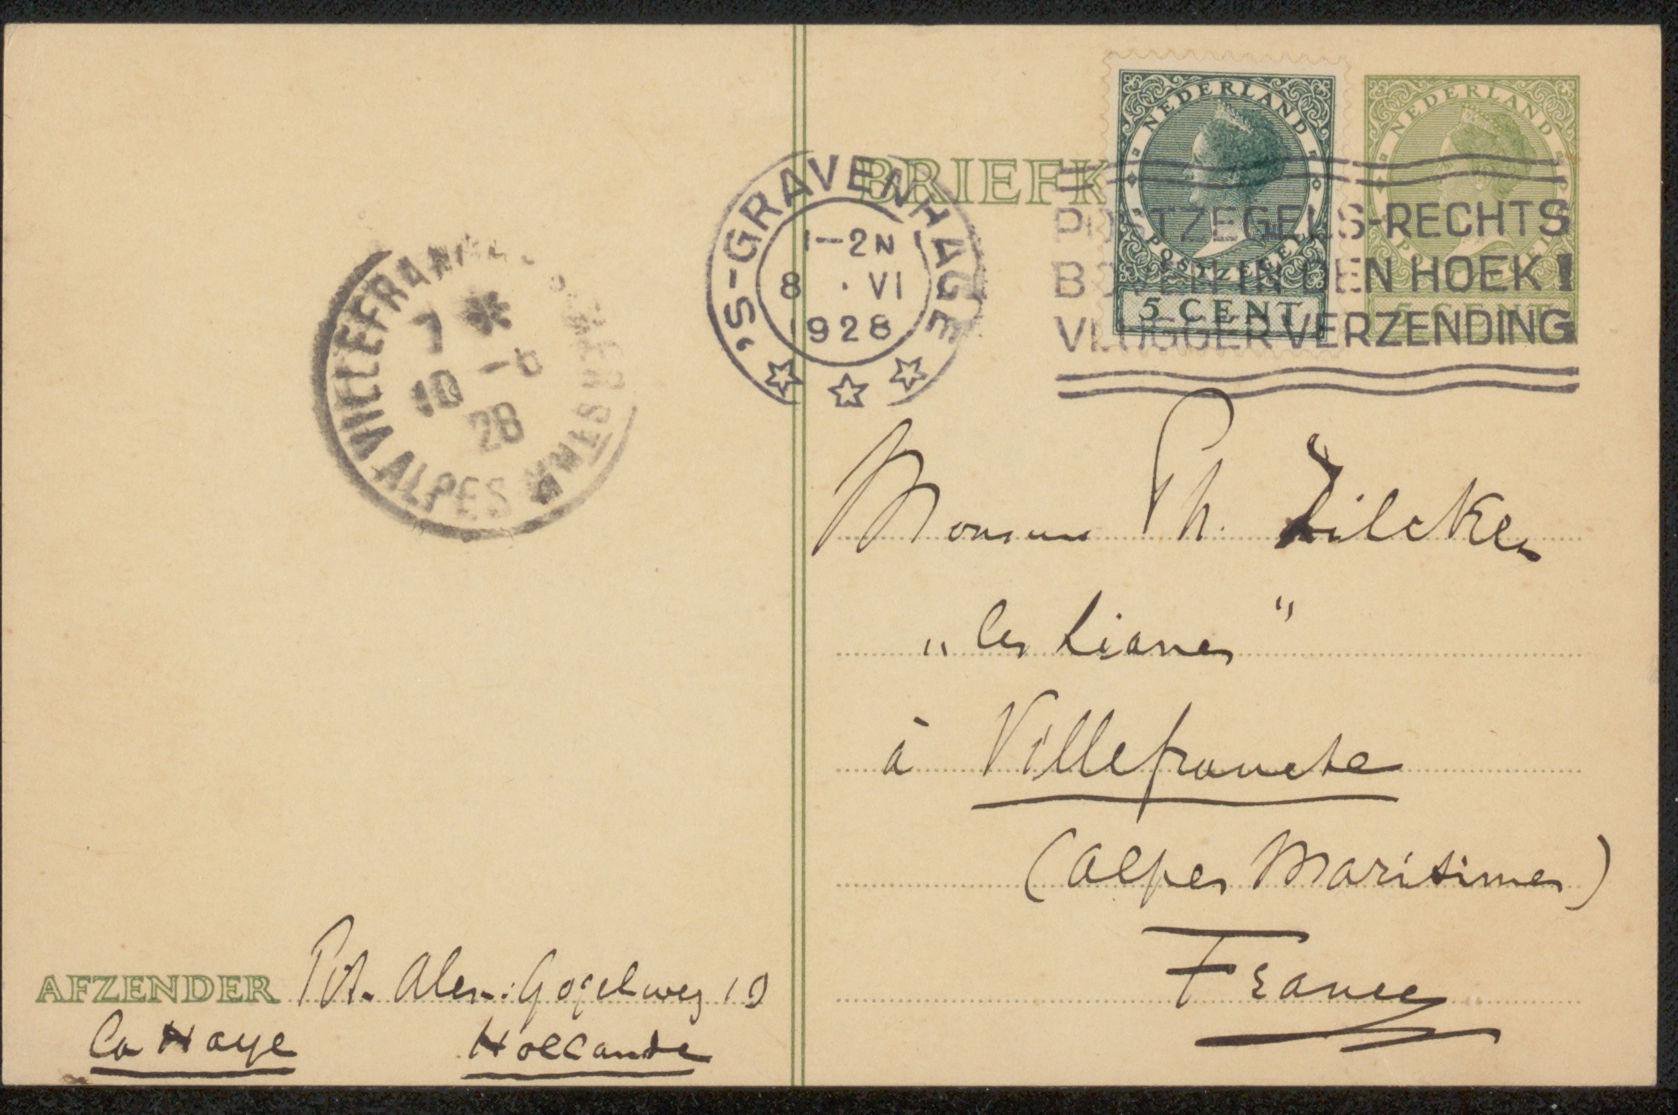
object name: postcard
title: Briefkaart aan Philip Zilcken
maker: adriaan pit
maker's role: print maker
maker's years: 1860-1944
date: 1928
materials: cardboard, ink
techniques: pen, writing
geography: the hague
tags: london, painter, print maker, draughtsman, matthijs maris, philip zilcken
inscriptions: collector's mark: ‘RPK’